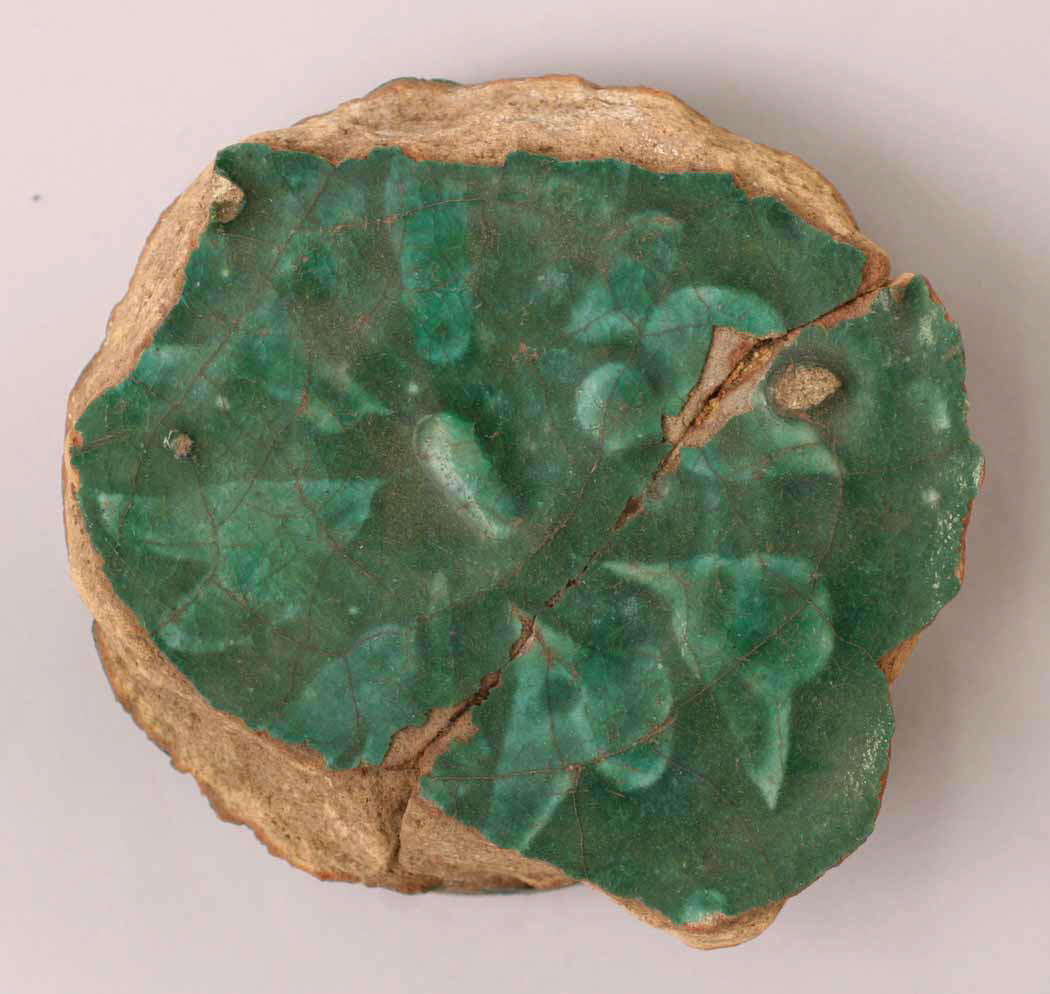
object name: ceramic fragment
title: Fragment of a Dish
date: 1301-1500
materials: earthenware, glaze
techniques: painting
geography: egypt